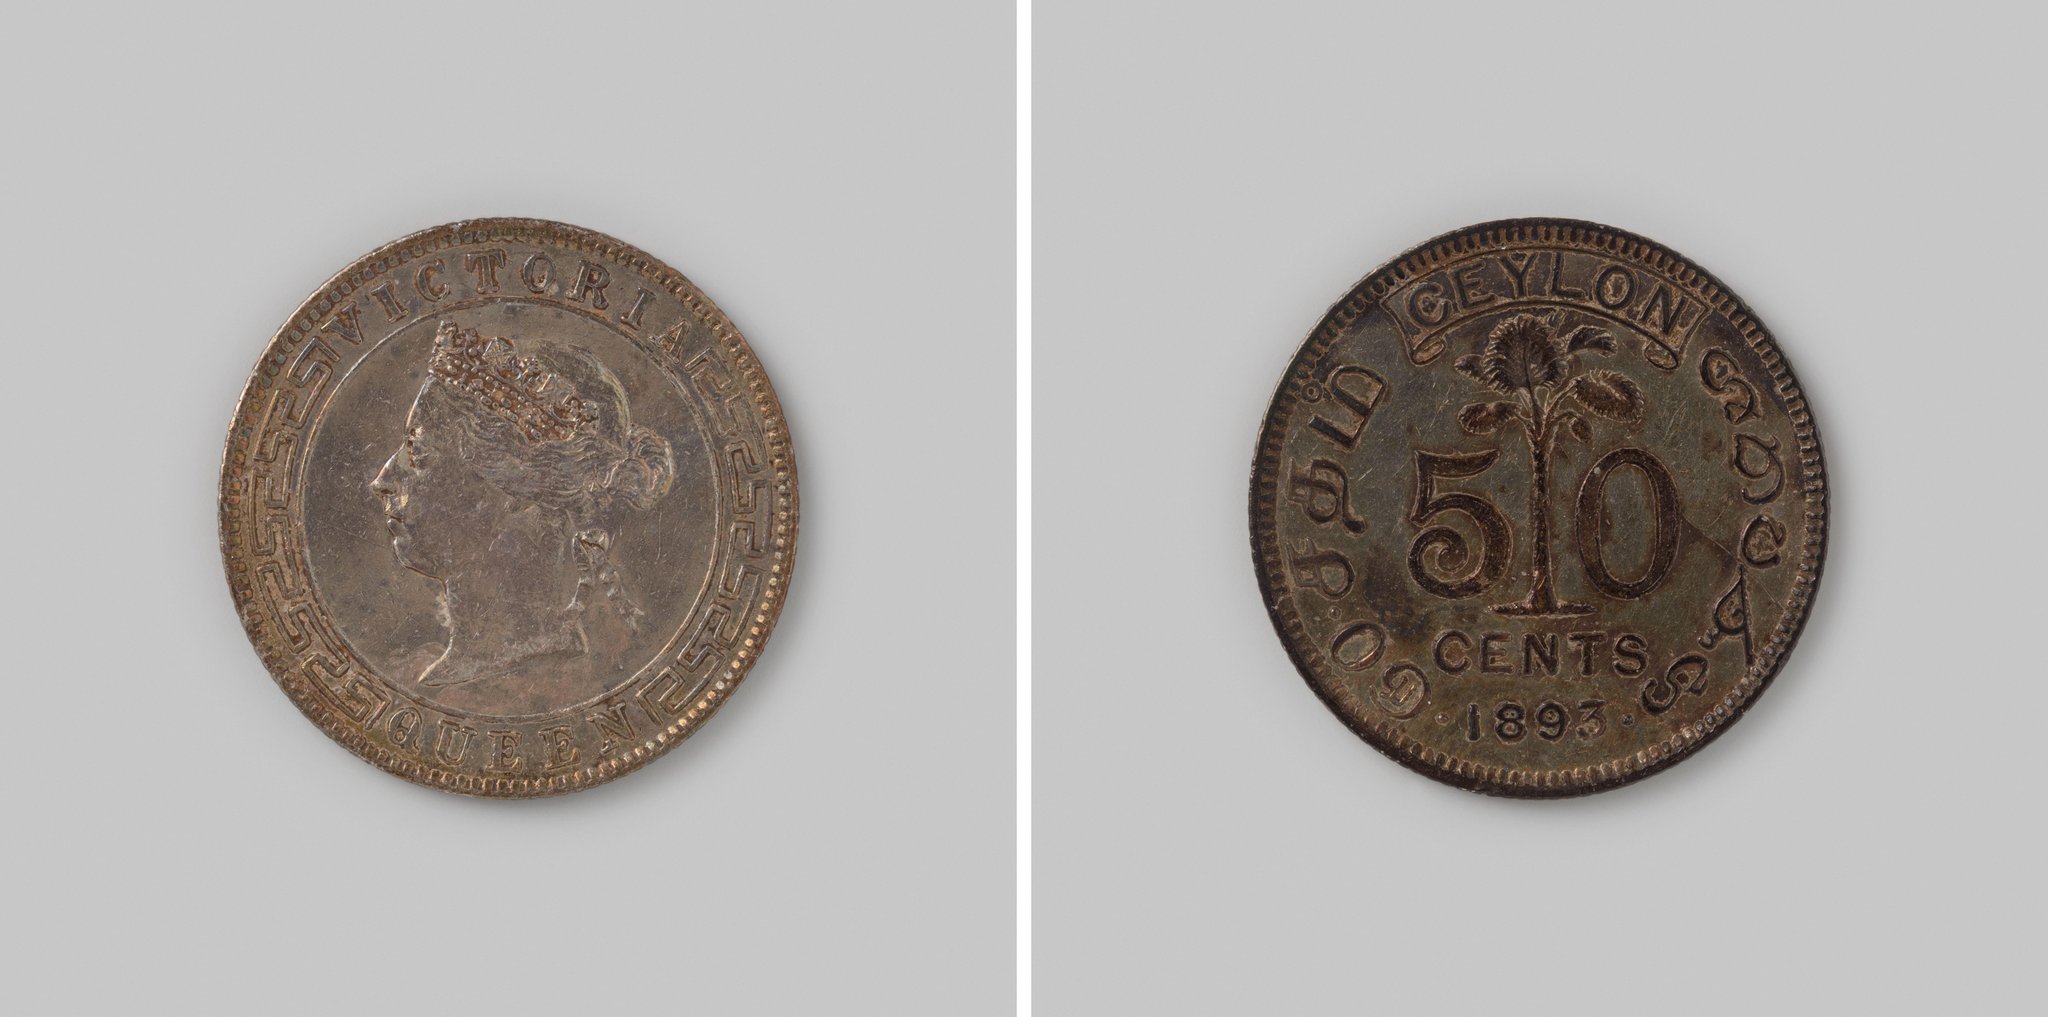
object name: coin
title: Sri Lanka, Ceylon, 50 cents op naam van koningin Victoria,1893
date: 1893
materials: silver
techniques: striking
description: Zilveren munt. Voorzijde: hoofd met diadeem van de koningin naar links. Keerzijde: tussen waarde-aanduiding - in twee regels - palmboom. Jaartal onderaan. Kartelrand.